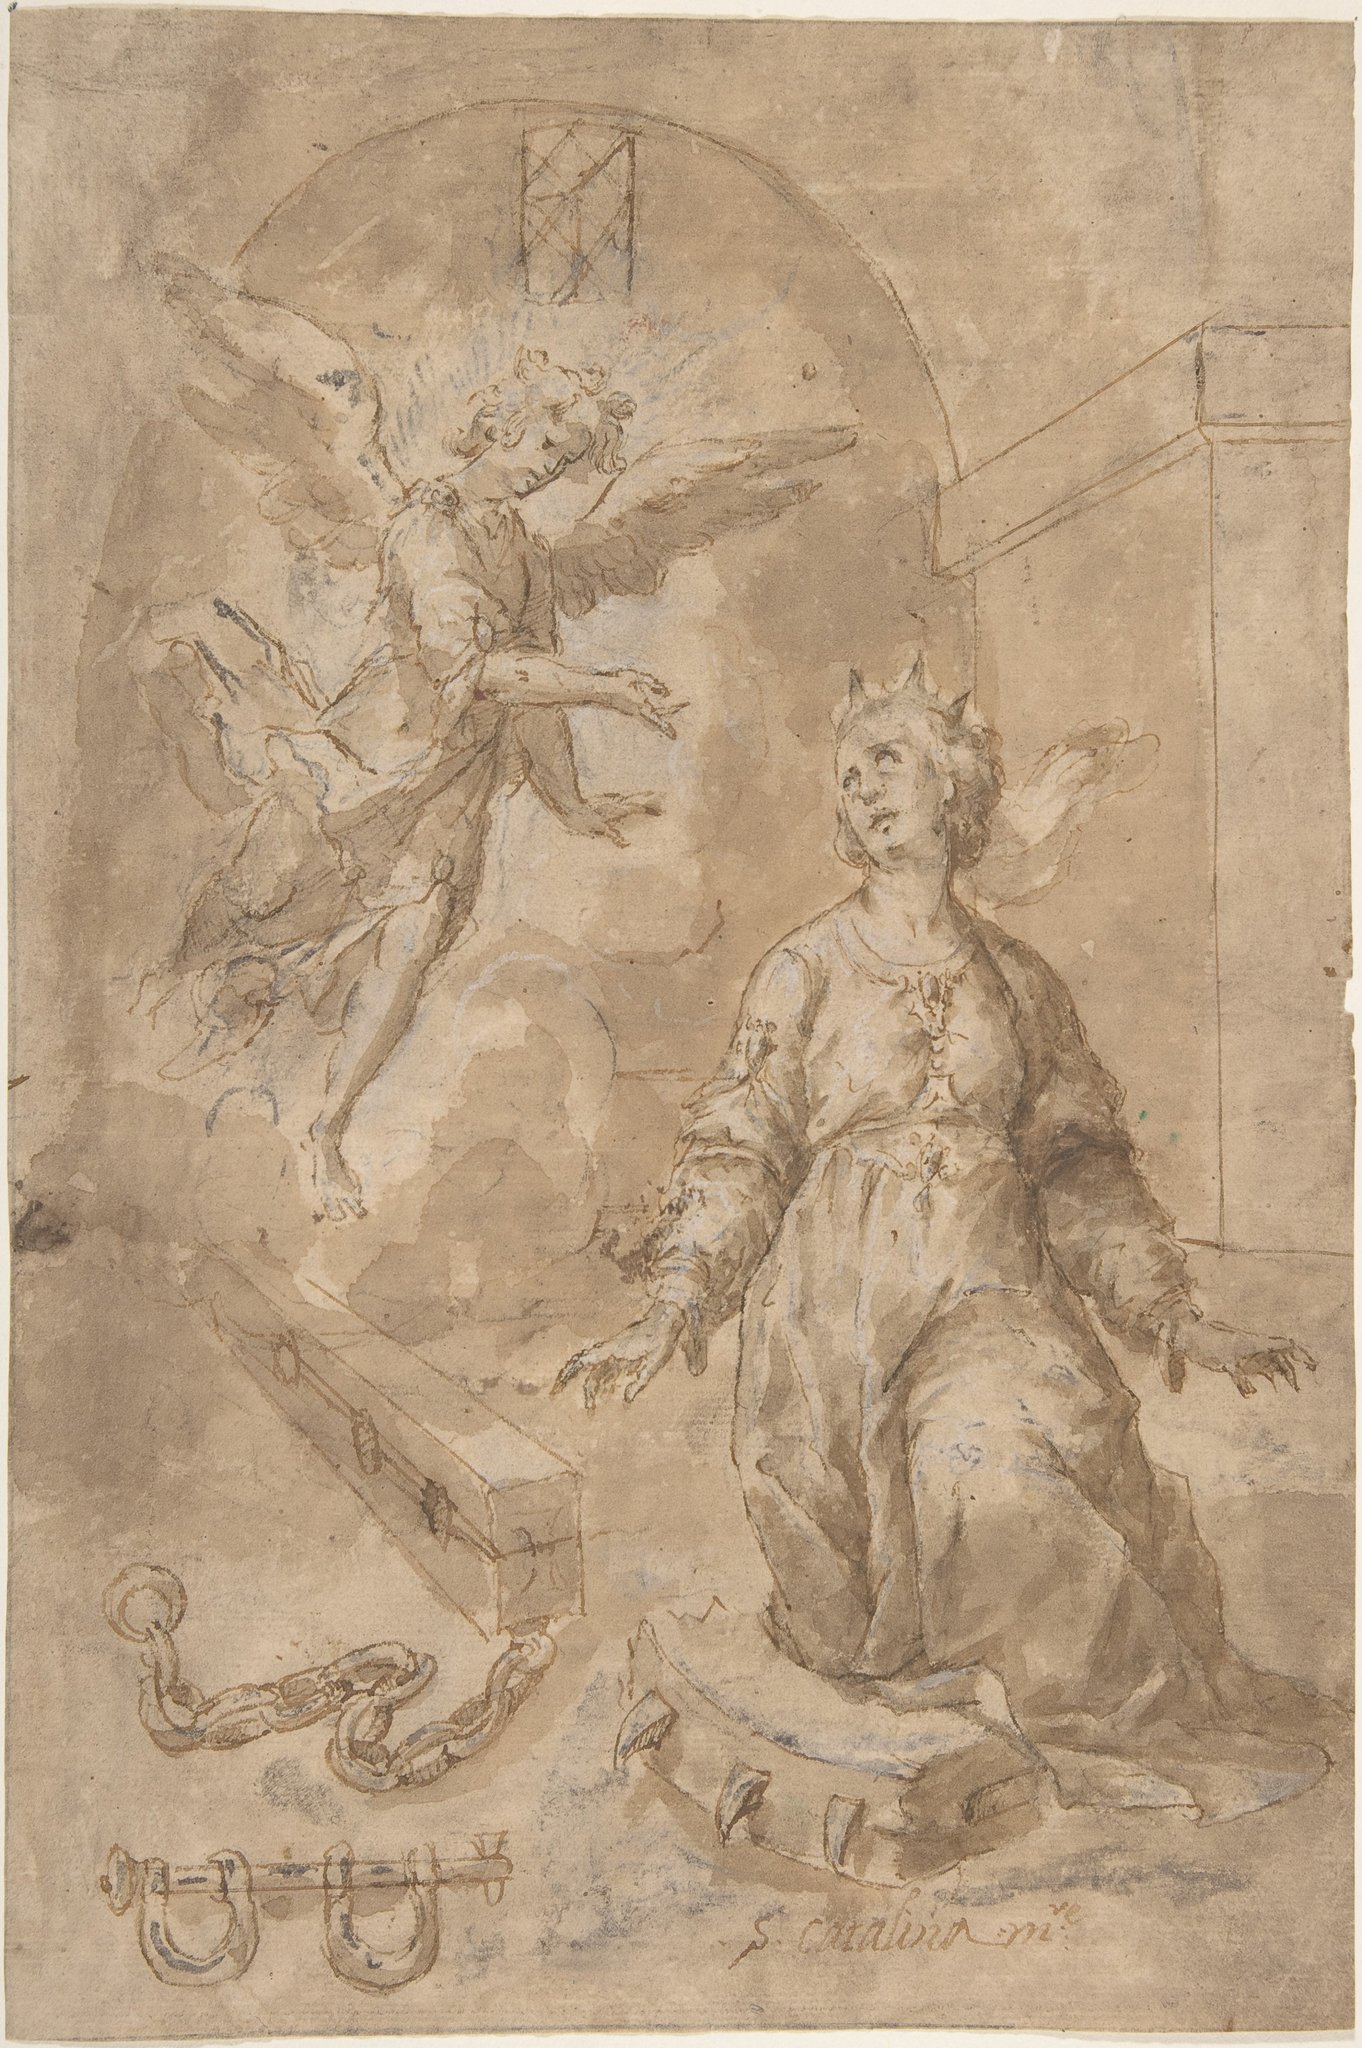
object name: drawing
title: An Angel Appearing to Saint Catherine of Alexandria in Prison (recto); Volute (verso)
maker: anonymous, spanish, school of seville, 17th century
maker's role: artist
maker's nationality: spanish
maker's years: 1600-1700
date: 1601-1700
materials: chalk, gouache, graphite, ink, paper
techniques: brush, highlighting, pen, wash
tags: prisons,prisoners,angels,saint catherine